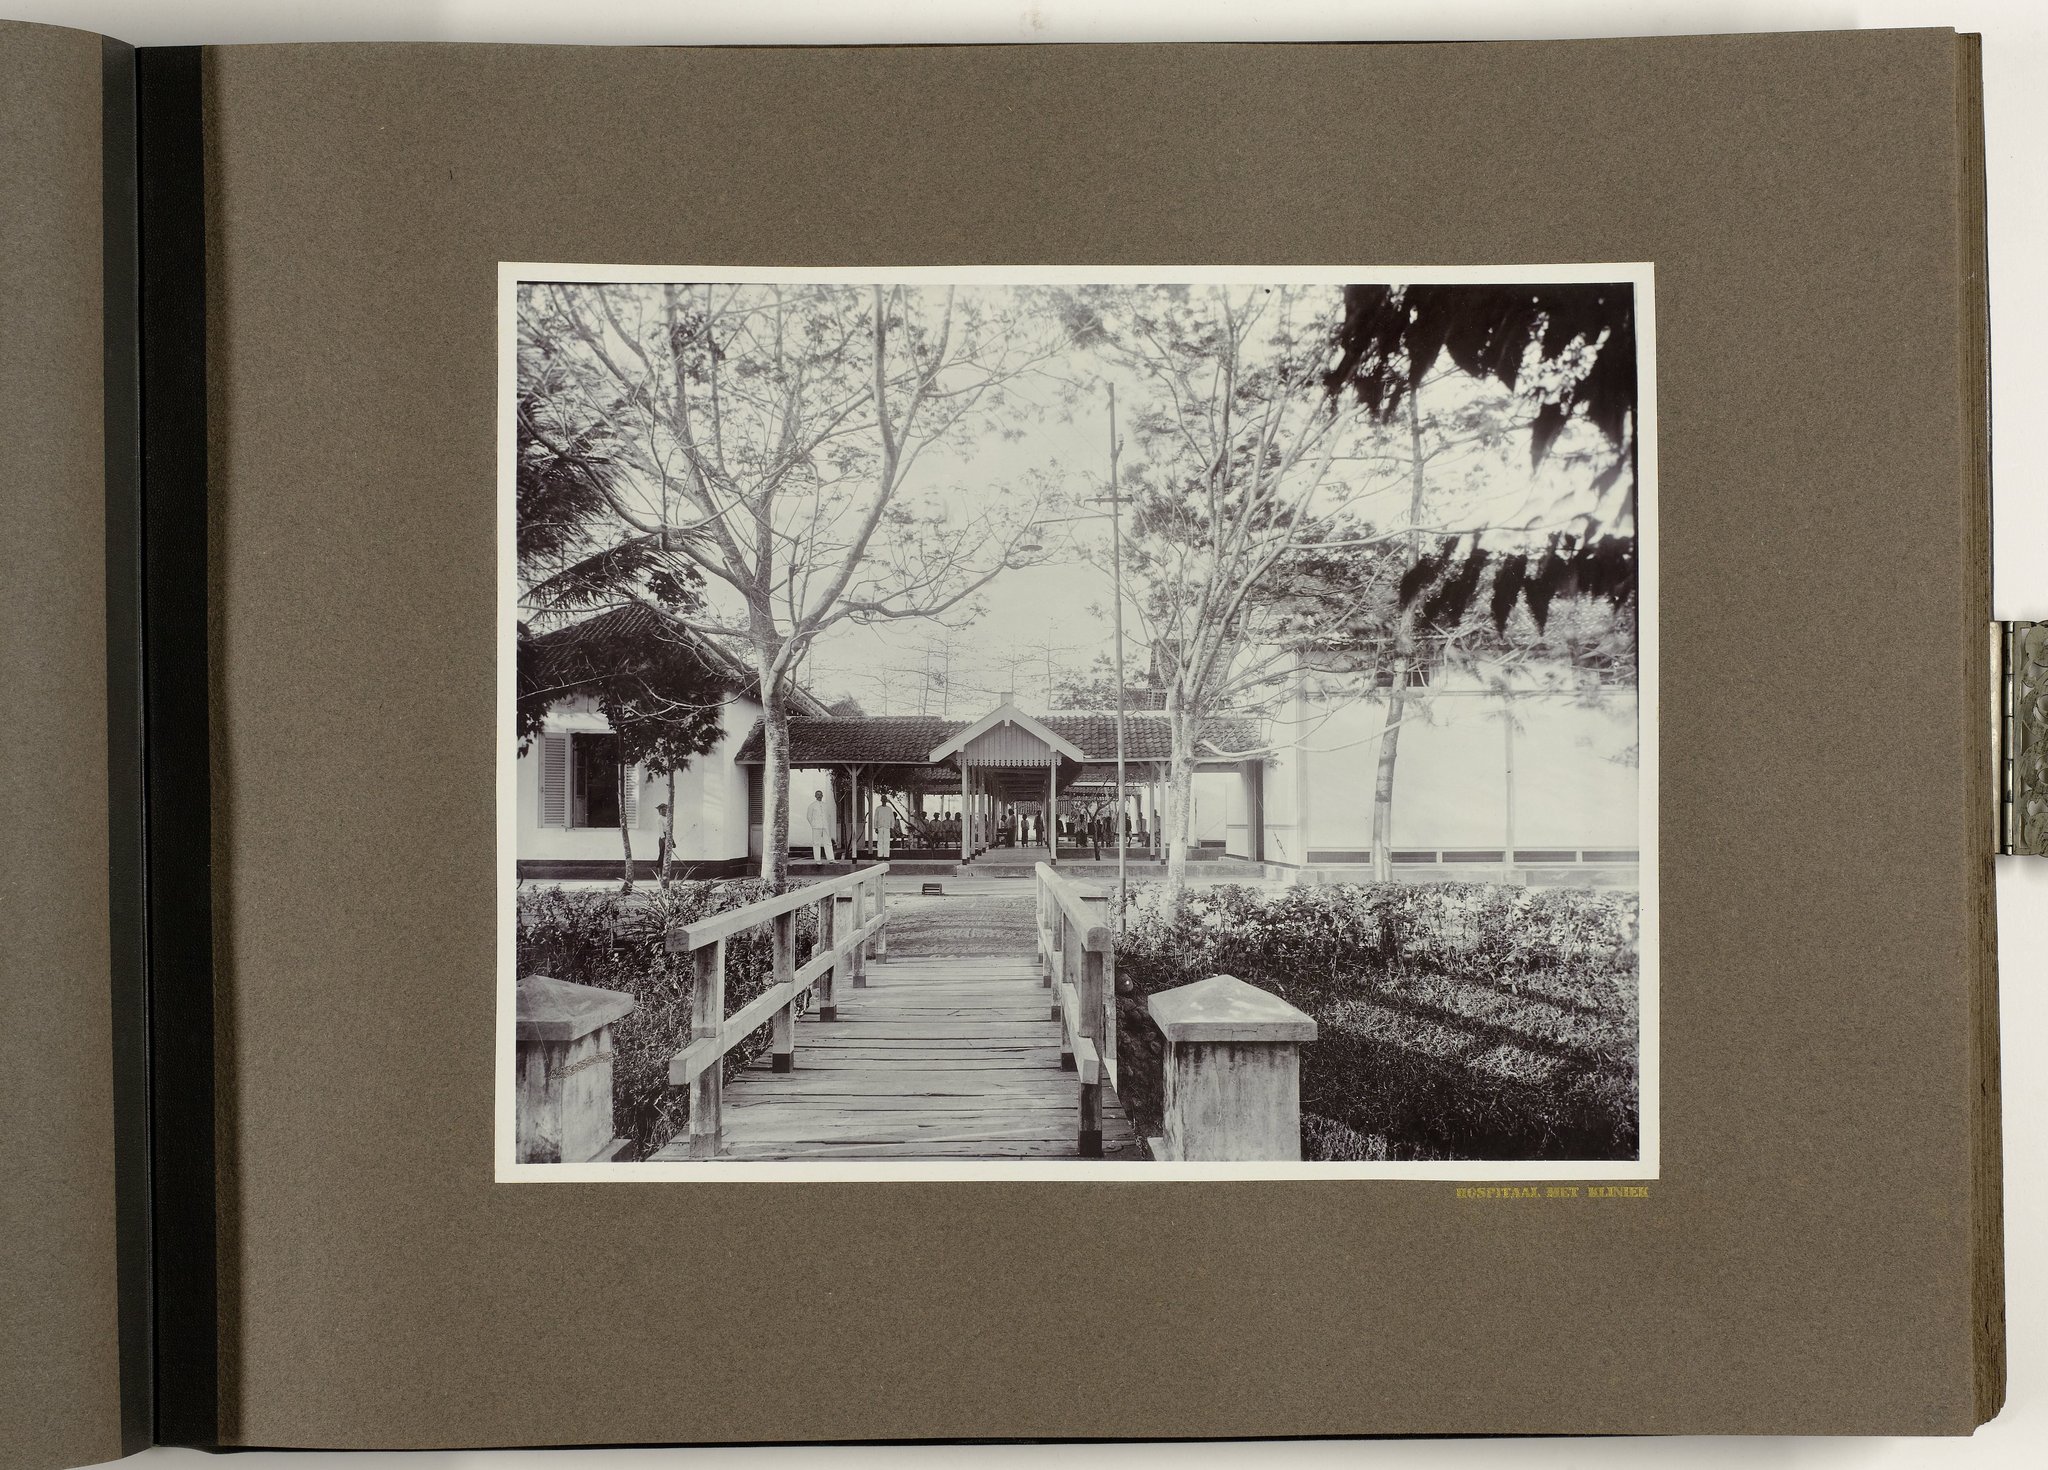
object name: photograph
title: Hospitaal met kliniek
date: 1917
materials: photographic support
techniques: gelatin silver print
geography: jatiroto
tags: colonial system, (non-fruit) products of plants or trees: sugarcane, hospital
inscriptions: inscription: ‘HOSPITAAL MET KLINIEK’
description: Hospitaal met kliniek behorend bij de suikerfabriek. Op de voorgrond een houten brug. Onderdeel van het fotoalbum aangeboden aan F.J. Wirix door het personeel van de Suikeronderneming Djatiroto in 1917.